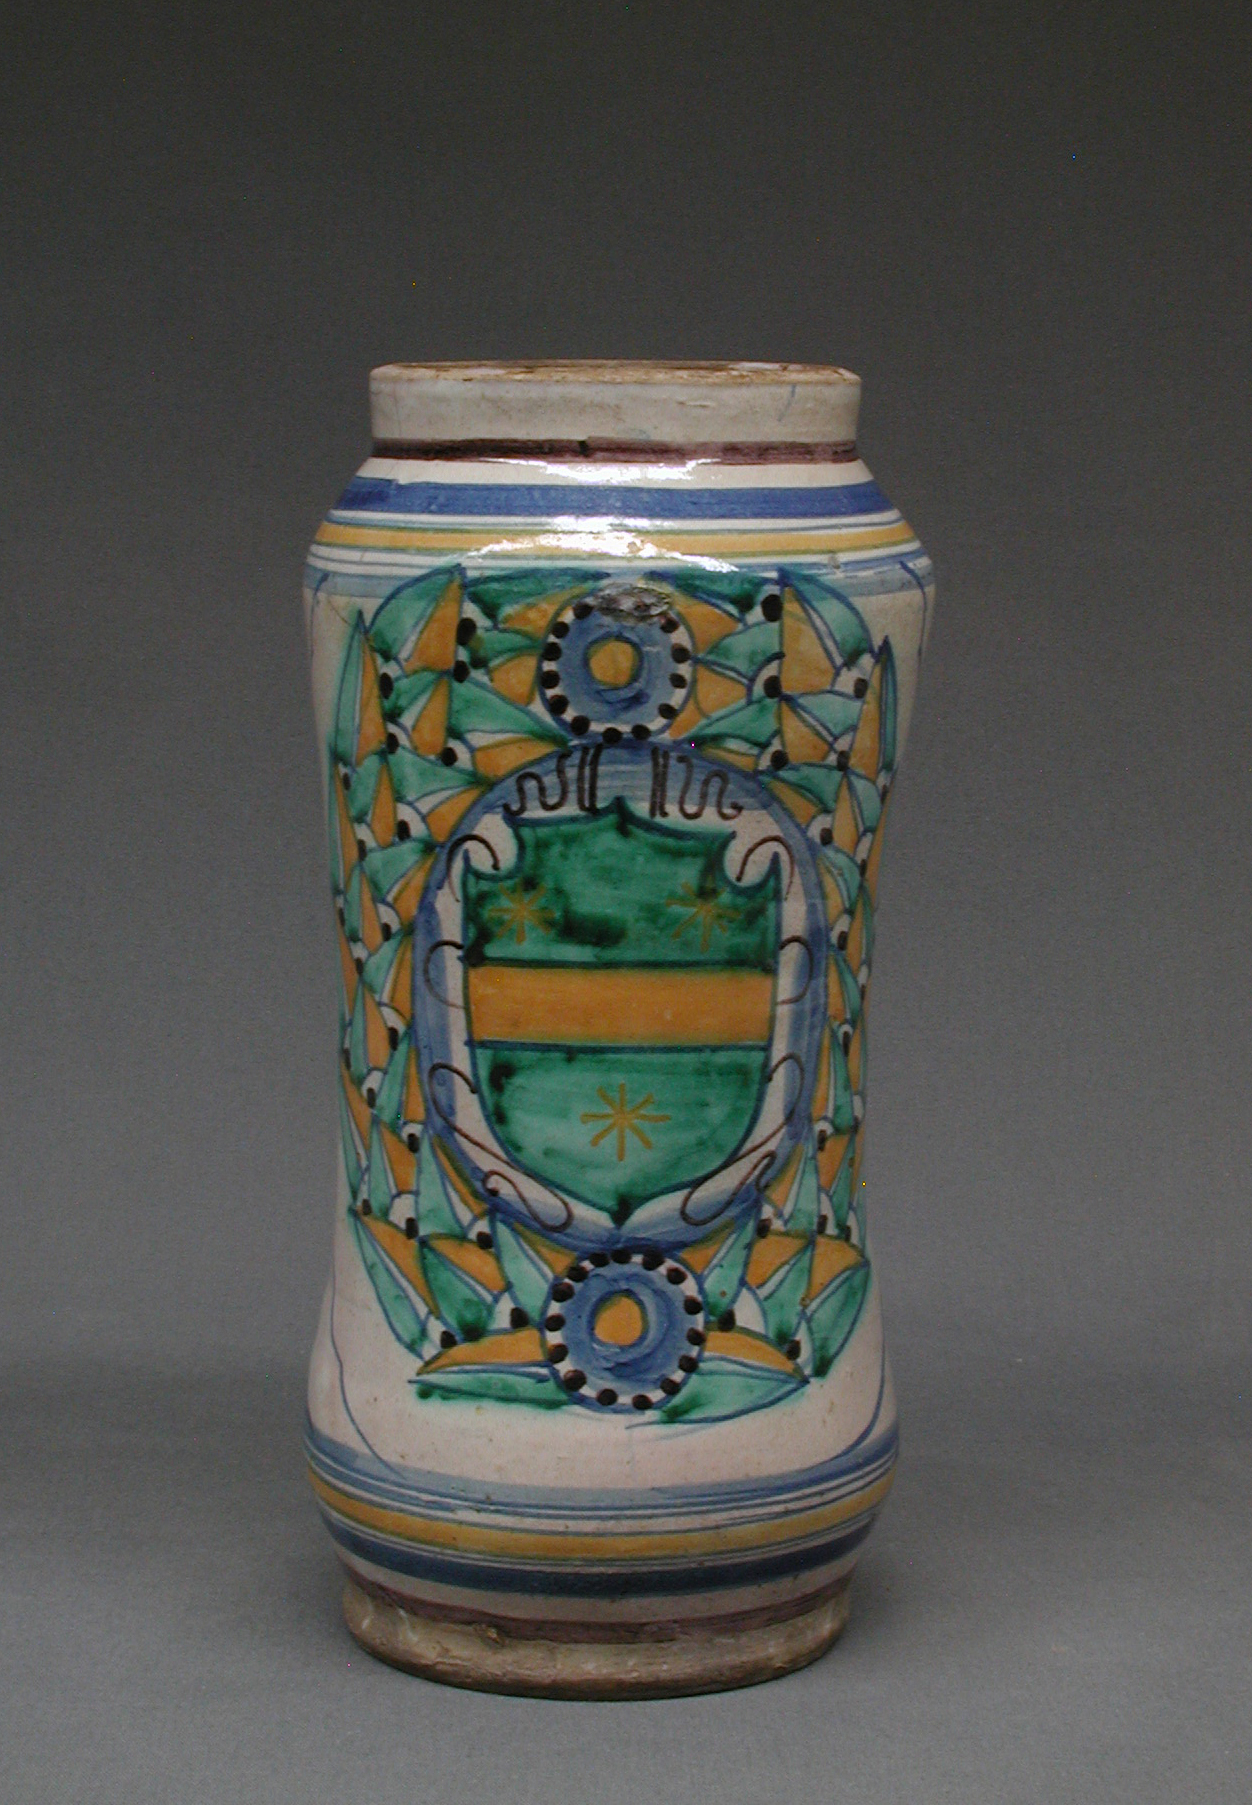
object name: albarello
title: Storage Jar (Albarello)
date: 1501-1600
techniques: maiolica, glazing